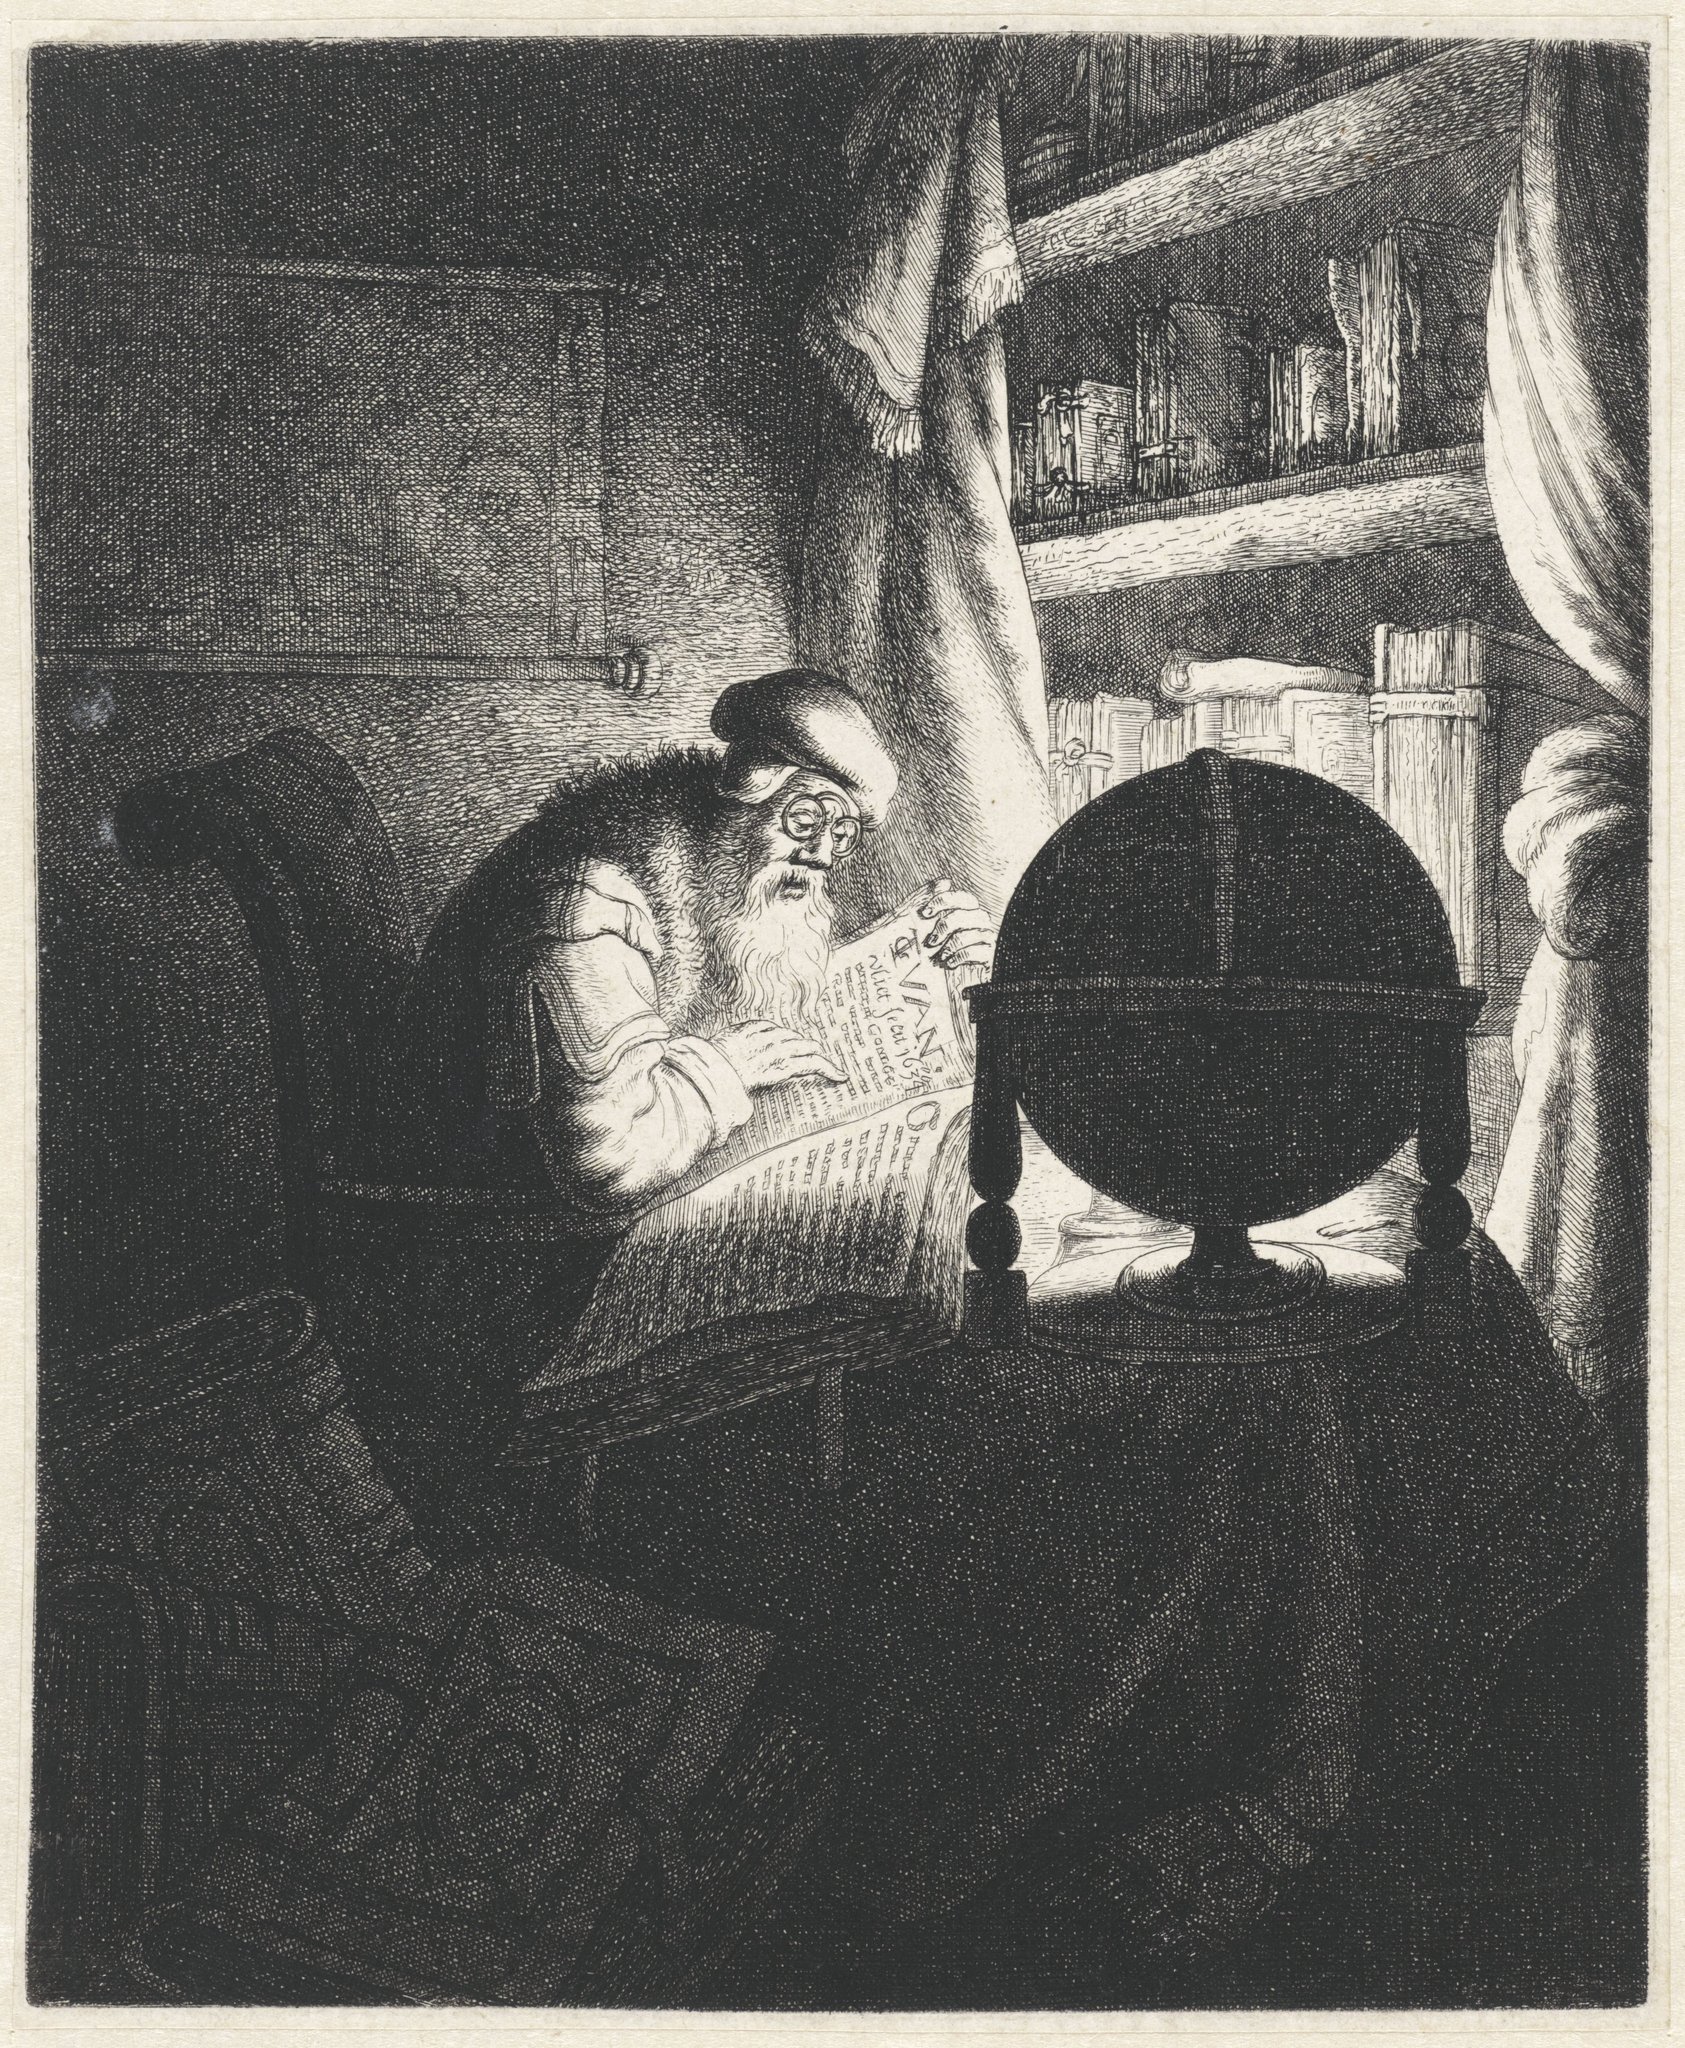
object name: print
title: Gezicht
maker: jan gillisz. van vliet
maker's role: draughtsman, painter, print maker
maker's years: 1600-1668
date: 1634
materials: paper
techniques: engraving, etching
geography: leiden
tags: eyeglasses, spectacles, sight, looking (one of the five senses), book - mm - book open, old man, study; 'studiolo'; library, book, globe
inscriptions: collector's mark: ‘F.D. 1839’ Lugt 985, inscription: ‘de Cl. no.31’, collector's mark: Lugt 2228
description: In een interieur zit een lezende oude man met een bril bij het licht van een kaars, die verborgen staat achter een globe. In het interieur ook een boekenkast en aan de achterwand een wandkaart.